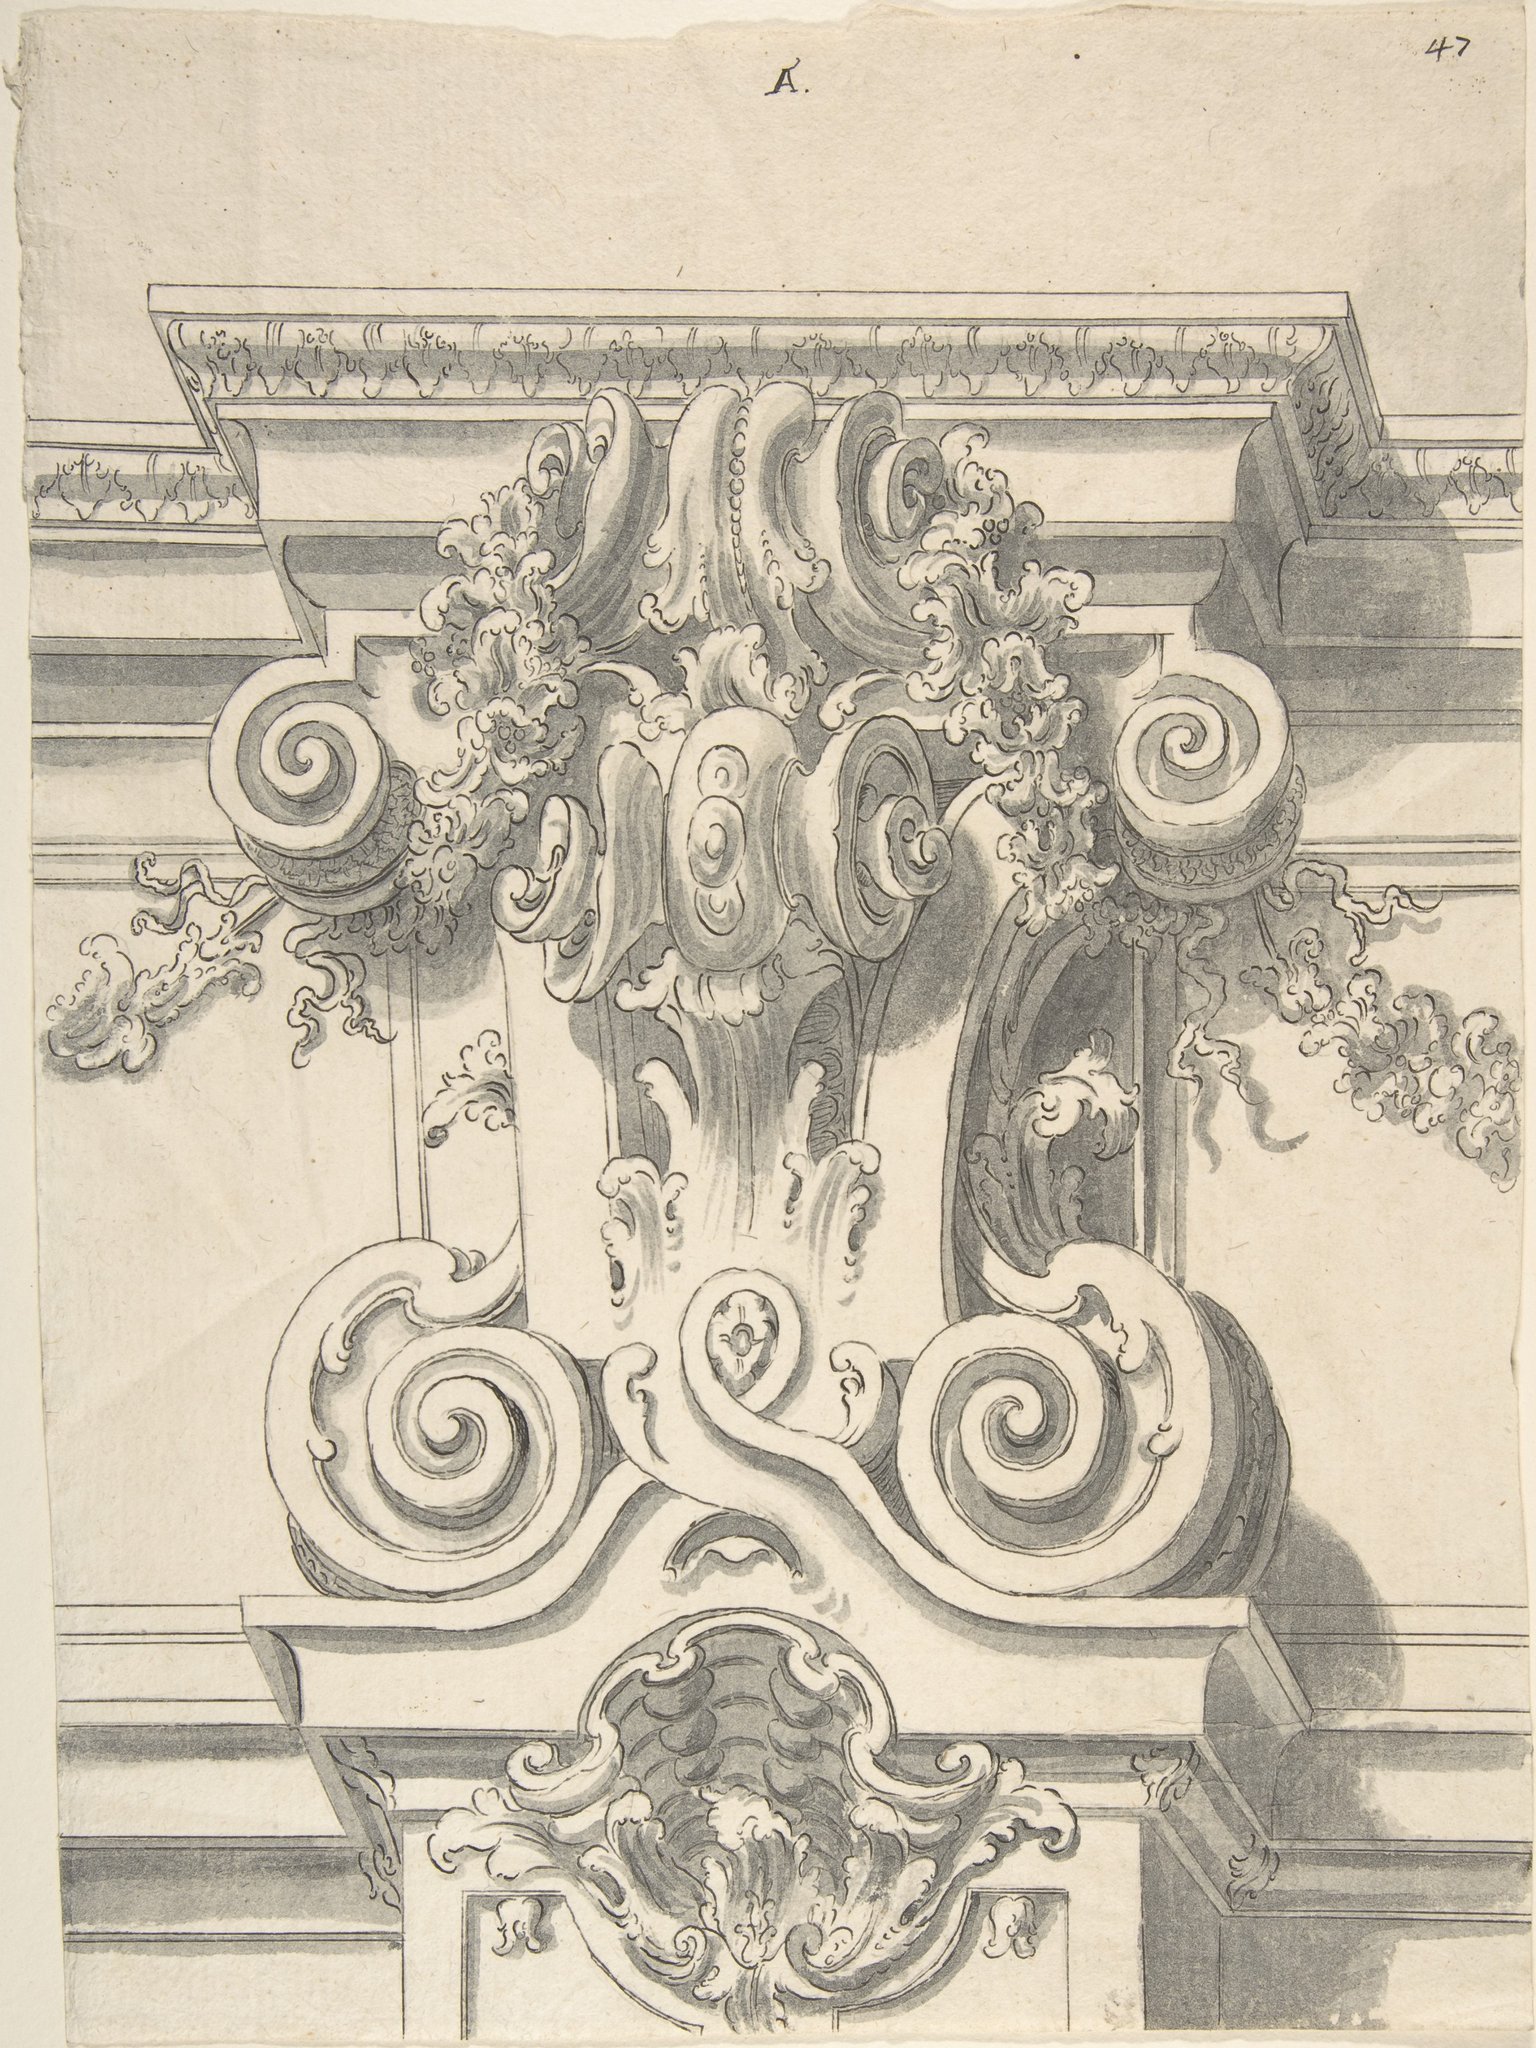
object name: drawing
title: Drawing for a Capital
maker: anonymous, italian, 18th century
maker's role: artist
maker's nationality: italian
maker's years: 1700-1800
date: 1701-1800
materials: ink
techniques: brush, pen, wash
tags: capitals